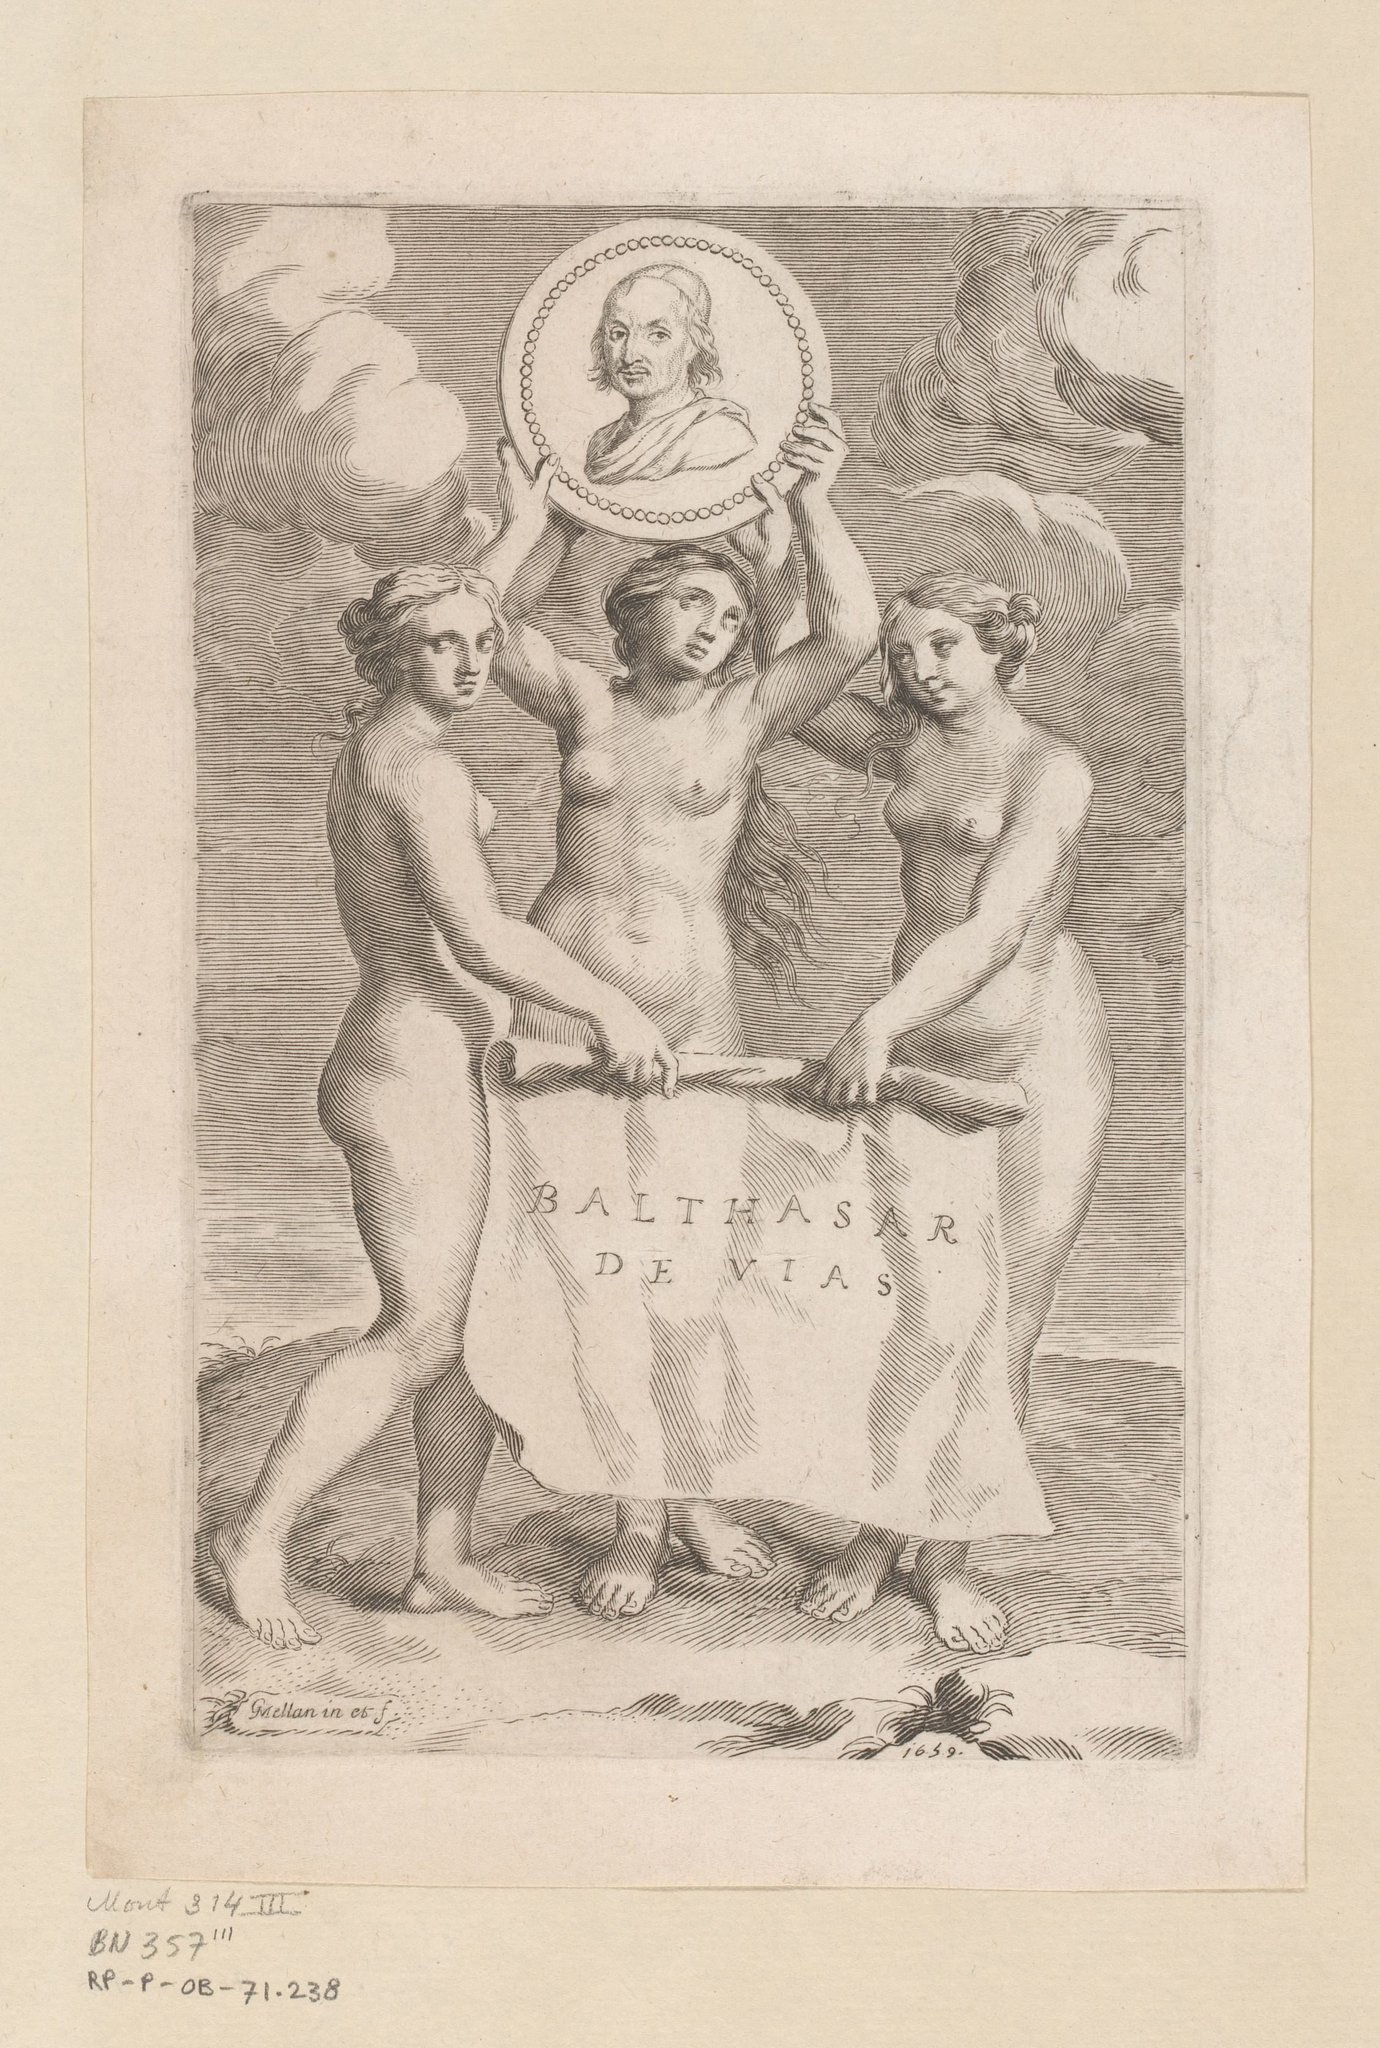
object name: titelblad, titelpagina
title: Drie Gratiën met een medaillon met het portret van Balthazar de Vias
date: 1659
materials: paper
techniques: engraving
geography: france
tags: ornament ~ medallion, historical persons, graces (charites), generally three in number; 'gratie' (ripa)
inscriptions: collector's mark: Lugt 240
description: Titelpagina voor: Vias, Balthazar de. Charitum libri tres. Parijs: Edmond Martin, 1660.